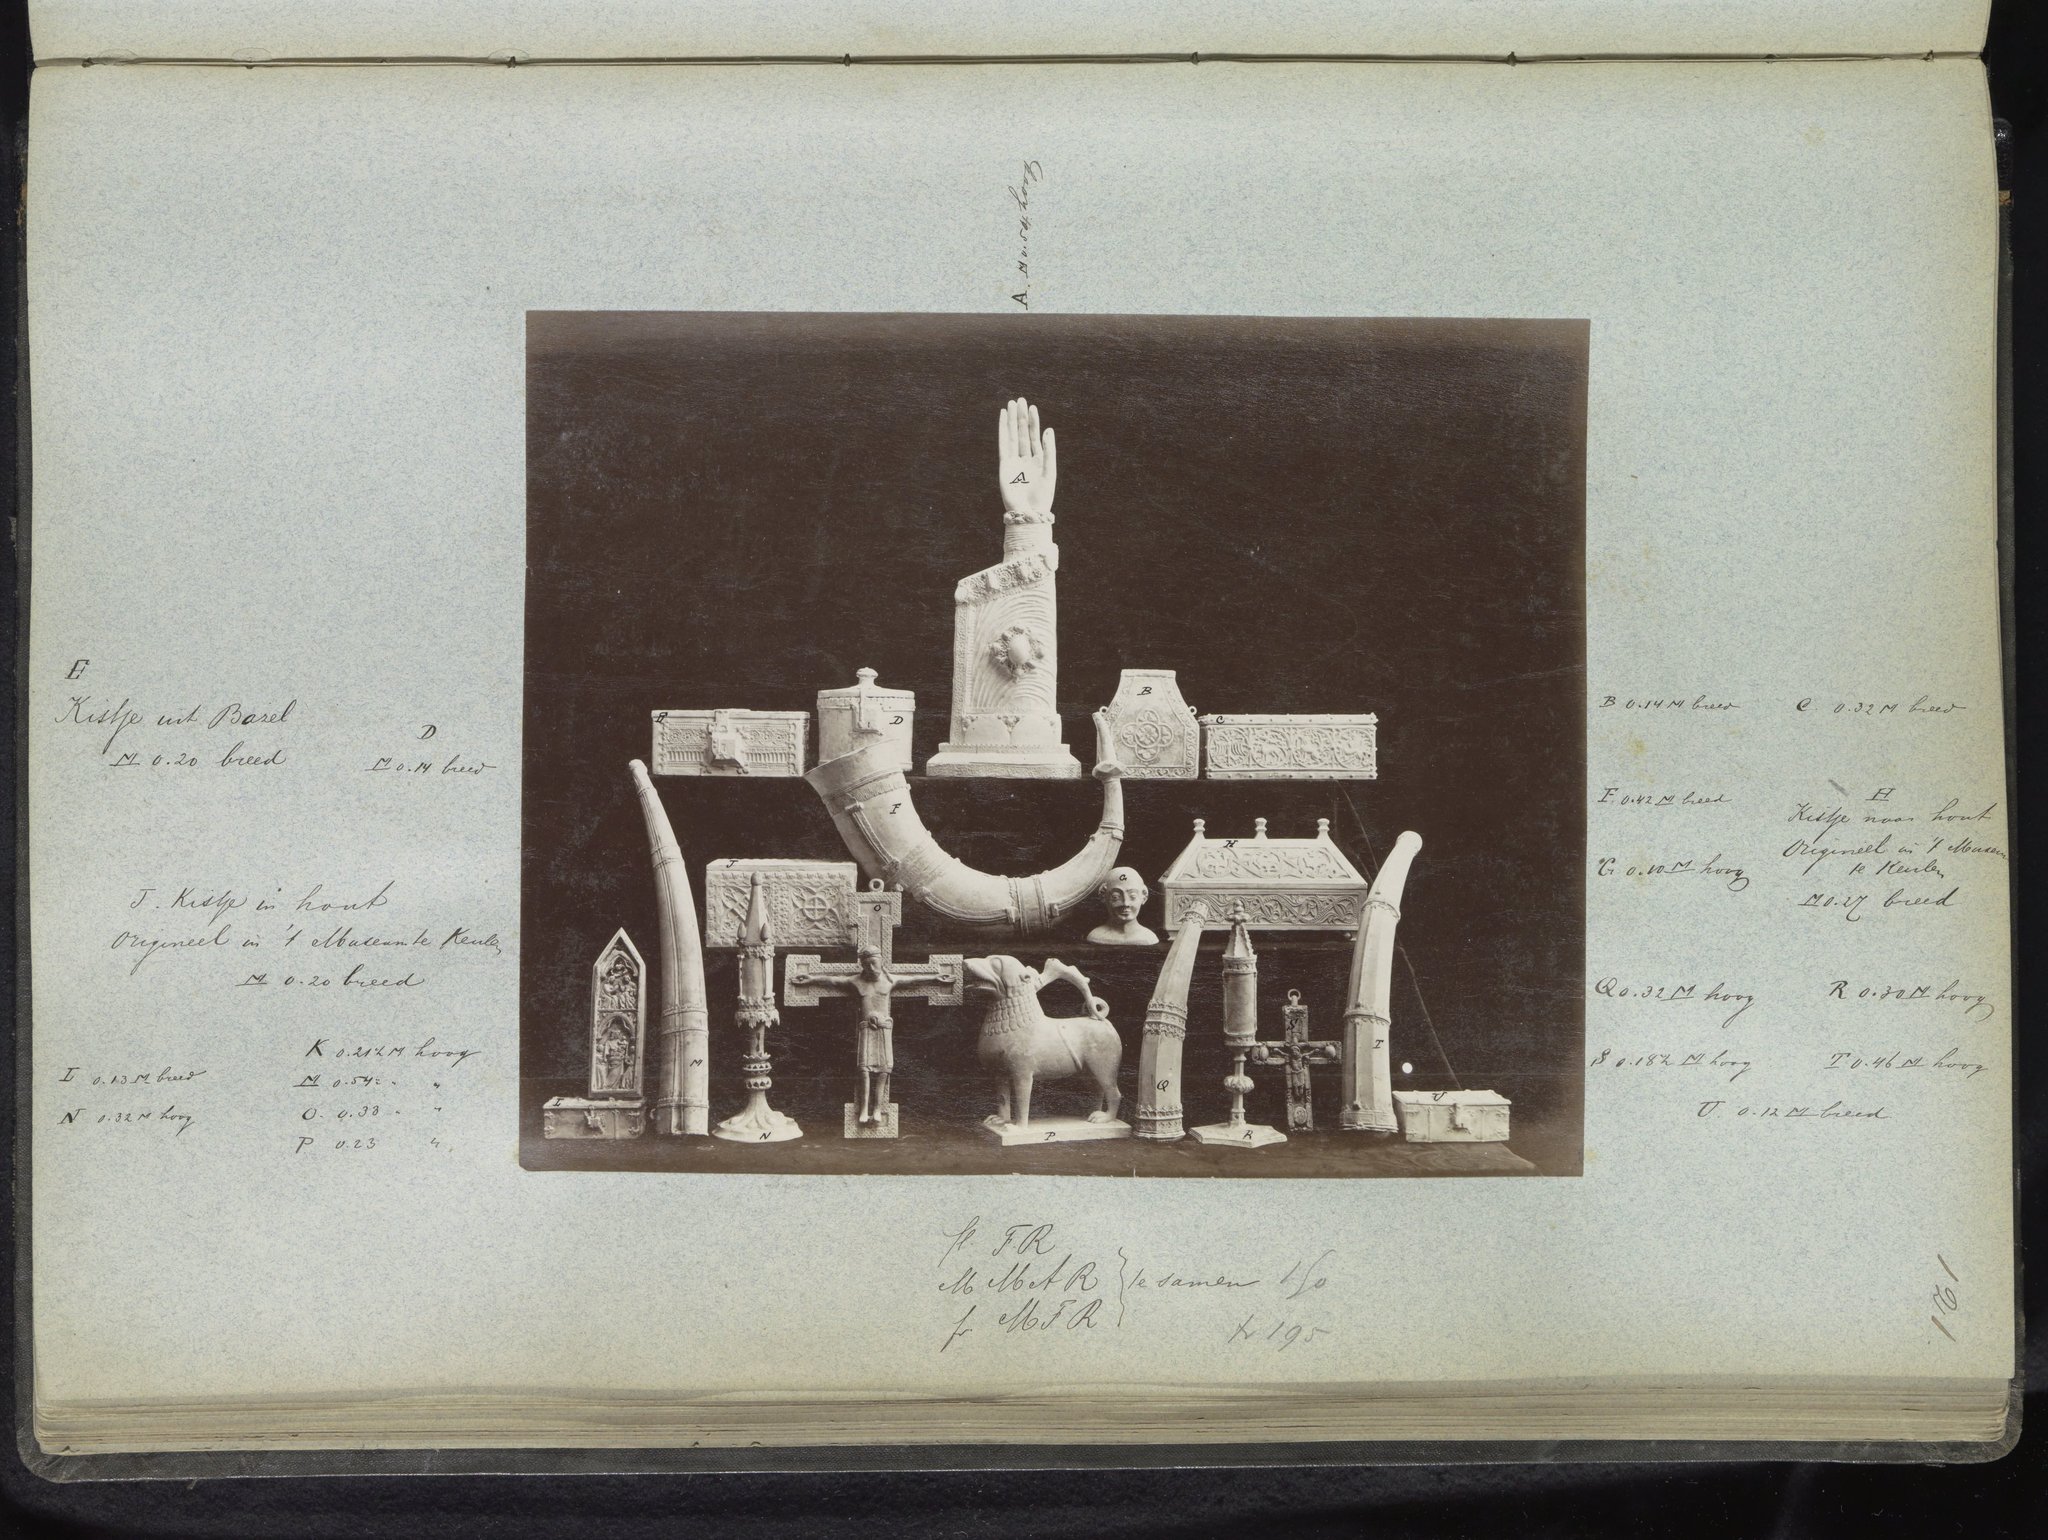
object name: album leaf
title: Gipsen afgietsels van onder meer kistjes, sculpturen van dieren, bustes en muziekinstrumenten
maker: Anonymous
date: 1875-1900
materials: paper, photographic support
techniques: albumen print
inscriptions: annotation, annotation